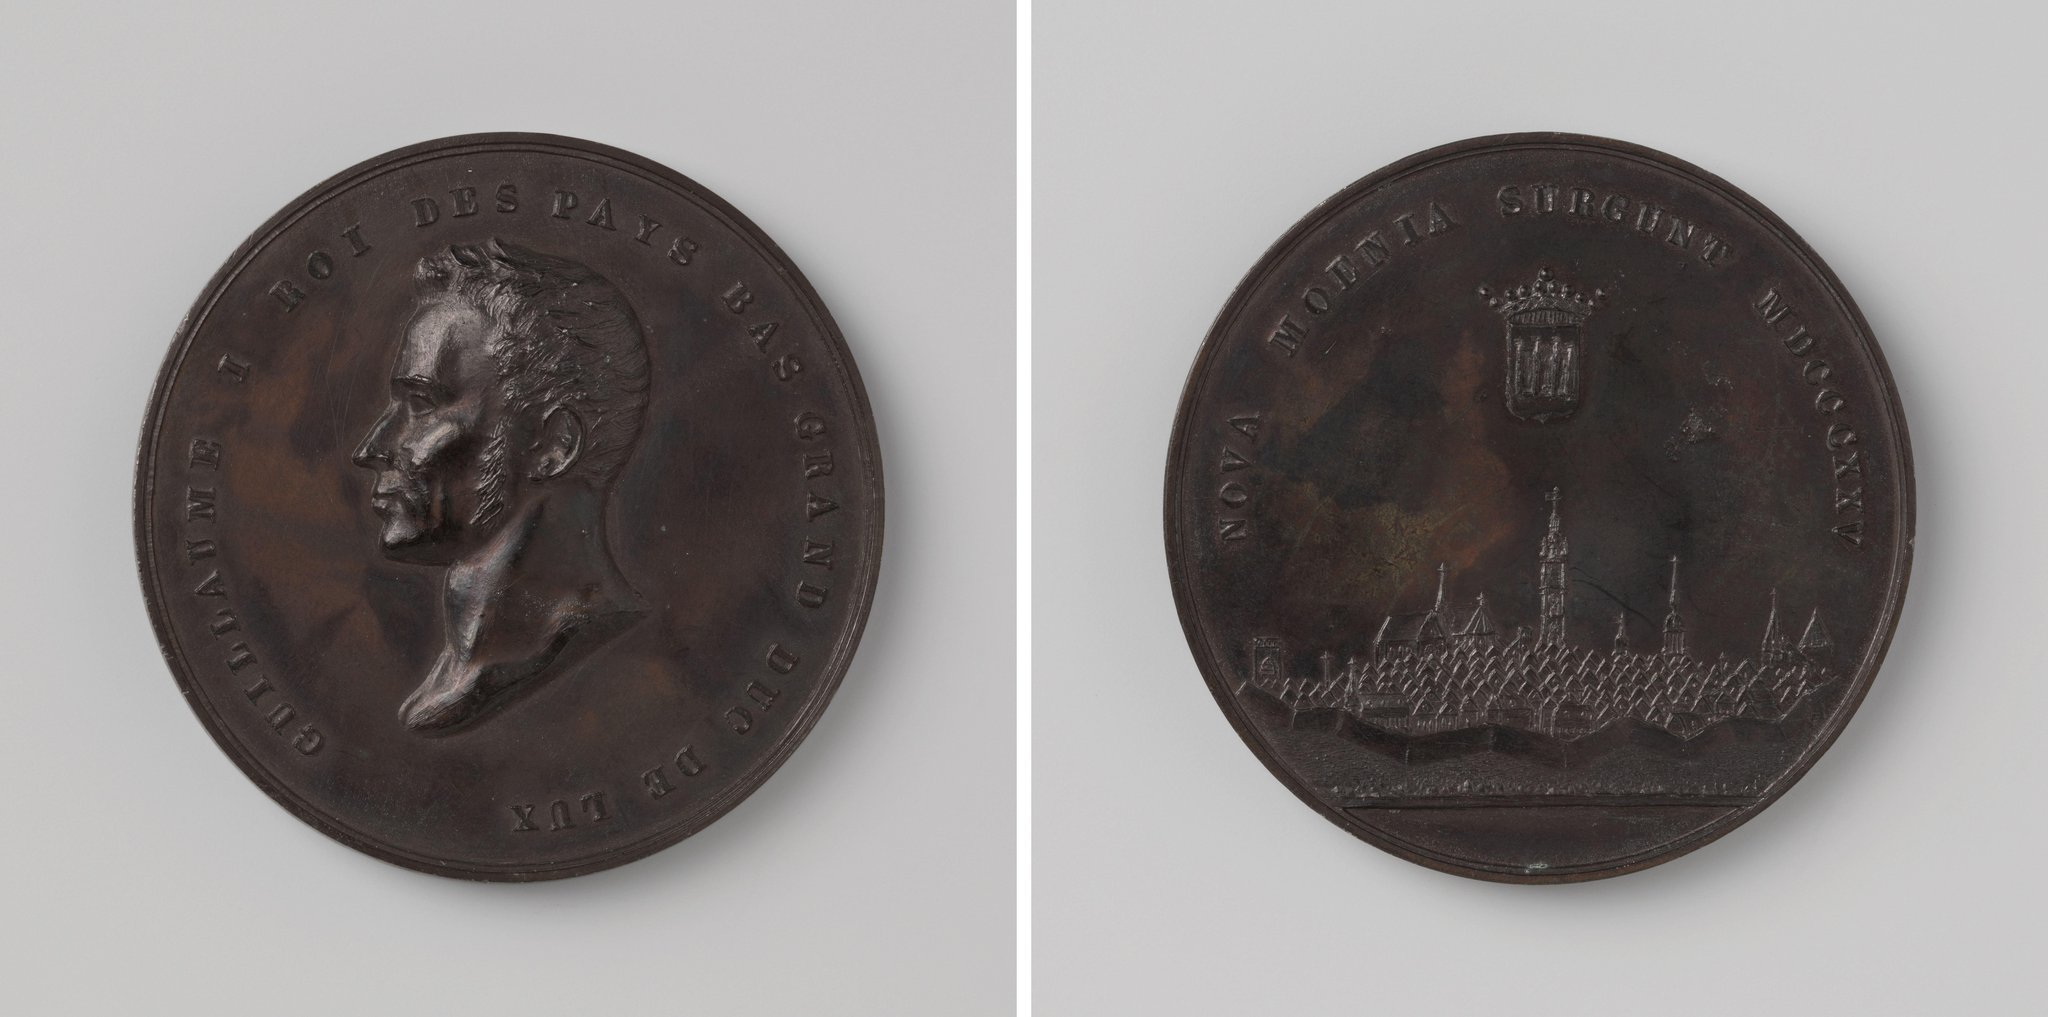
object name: history medal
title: Aanleg van nieuwe vestingswerken te Bergen in Henegouwen, ter ere van Willem I Frederik, koning der Nederlanden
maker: Anonymous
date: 1825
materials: bronze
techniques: striking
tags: william i of the netherlands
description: Bronzen penning. Voorzijde: borststuk man binnen omschrift. Keerzijde: gezicht op stad Bergen binnen nieuwe vestingswerken; daarboven gekroond wapenschild binnen omschrift.